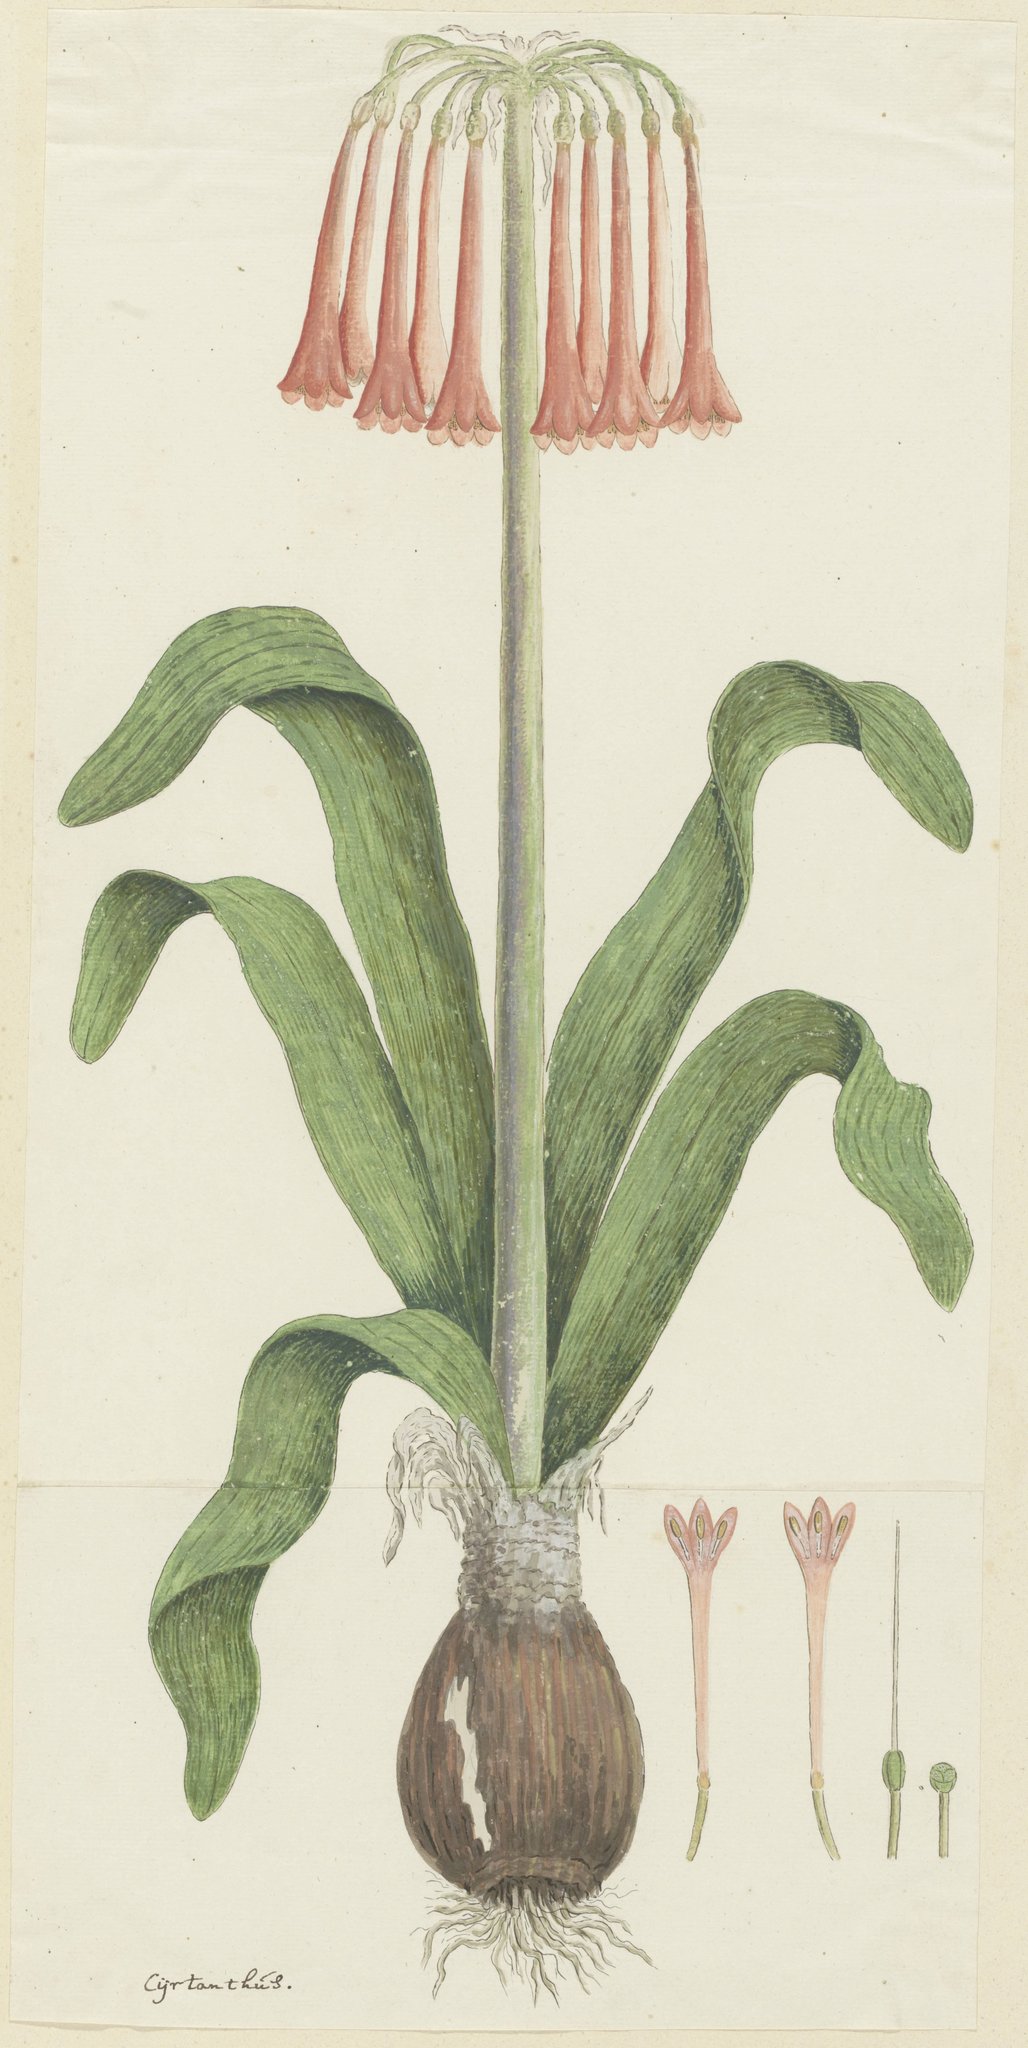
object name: album leaf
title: Cyrtanthus carneus Lindl. (Sand-lily)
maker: robert jacob gordon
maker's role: draughtsman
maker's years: 1743-1795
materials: chalk, paint, ink, paper, pencil, watercolor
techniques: brush, pen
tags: plants; vegetation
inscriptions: annotation: ‘Cijrtanthús’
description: De tekening is gemaakt voor of tijdens een van Gordon's vier expedities door de Kaapprovincie, van oktober 1777 tot maart 1786. Sommige (soort)namen kunnen zijn gewijzigd, gezien reorganisatie in plantentaxonomie gedurende de afgelopen jaren.